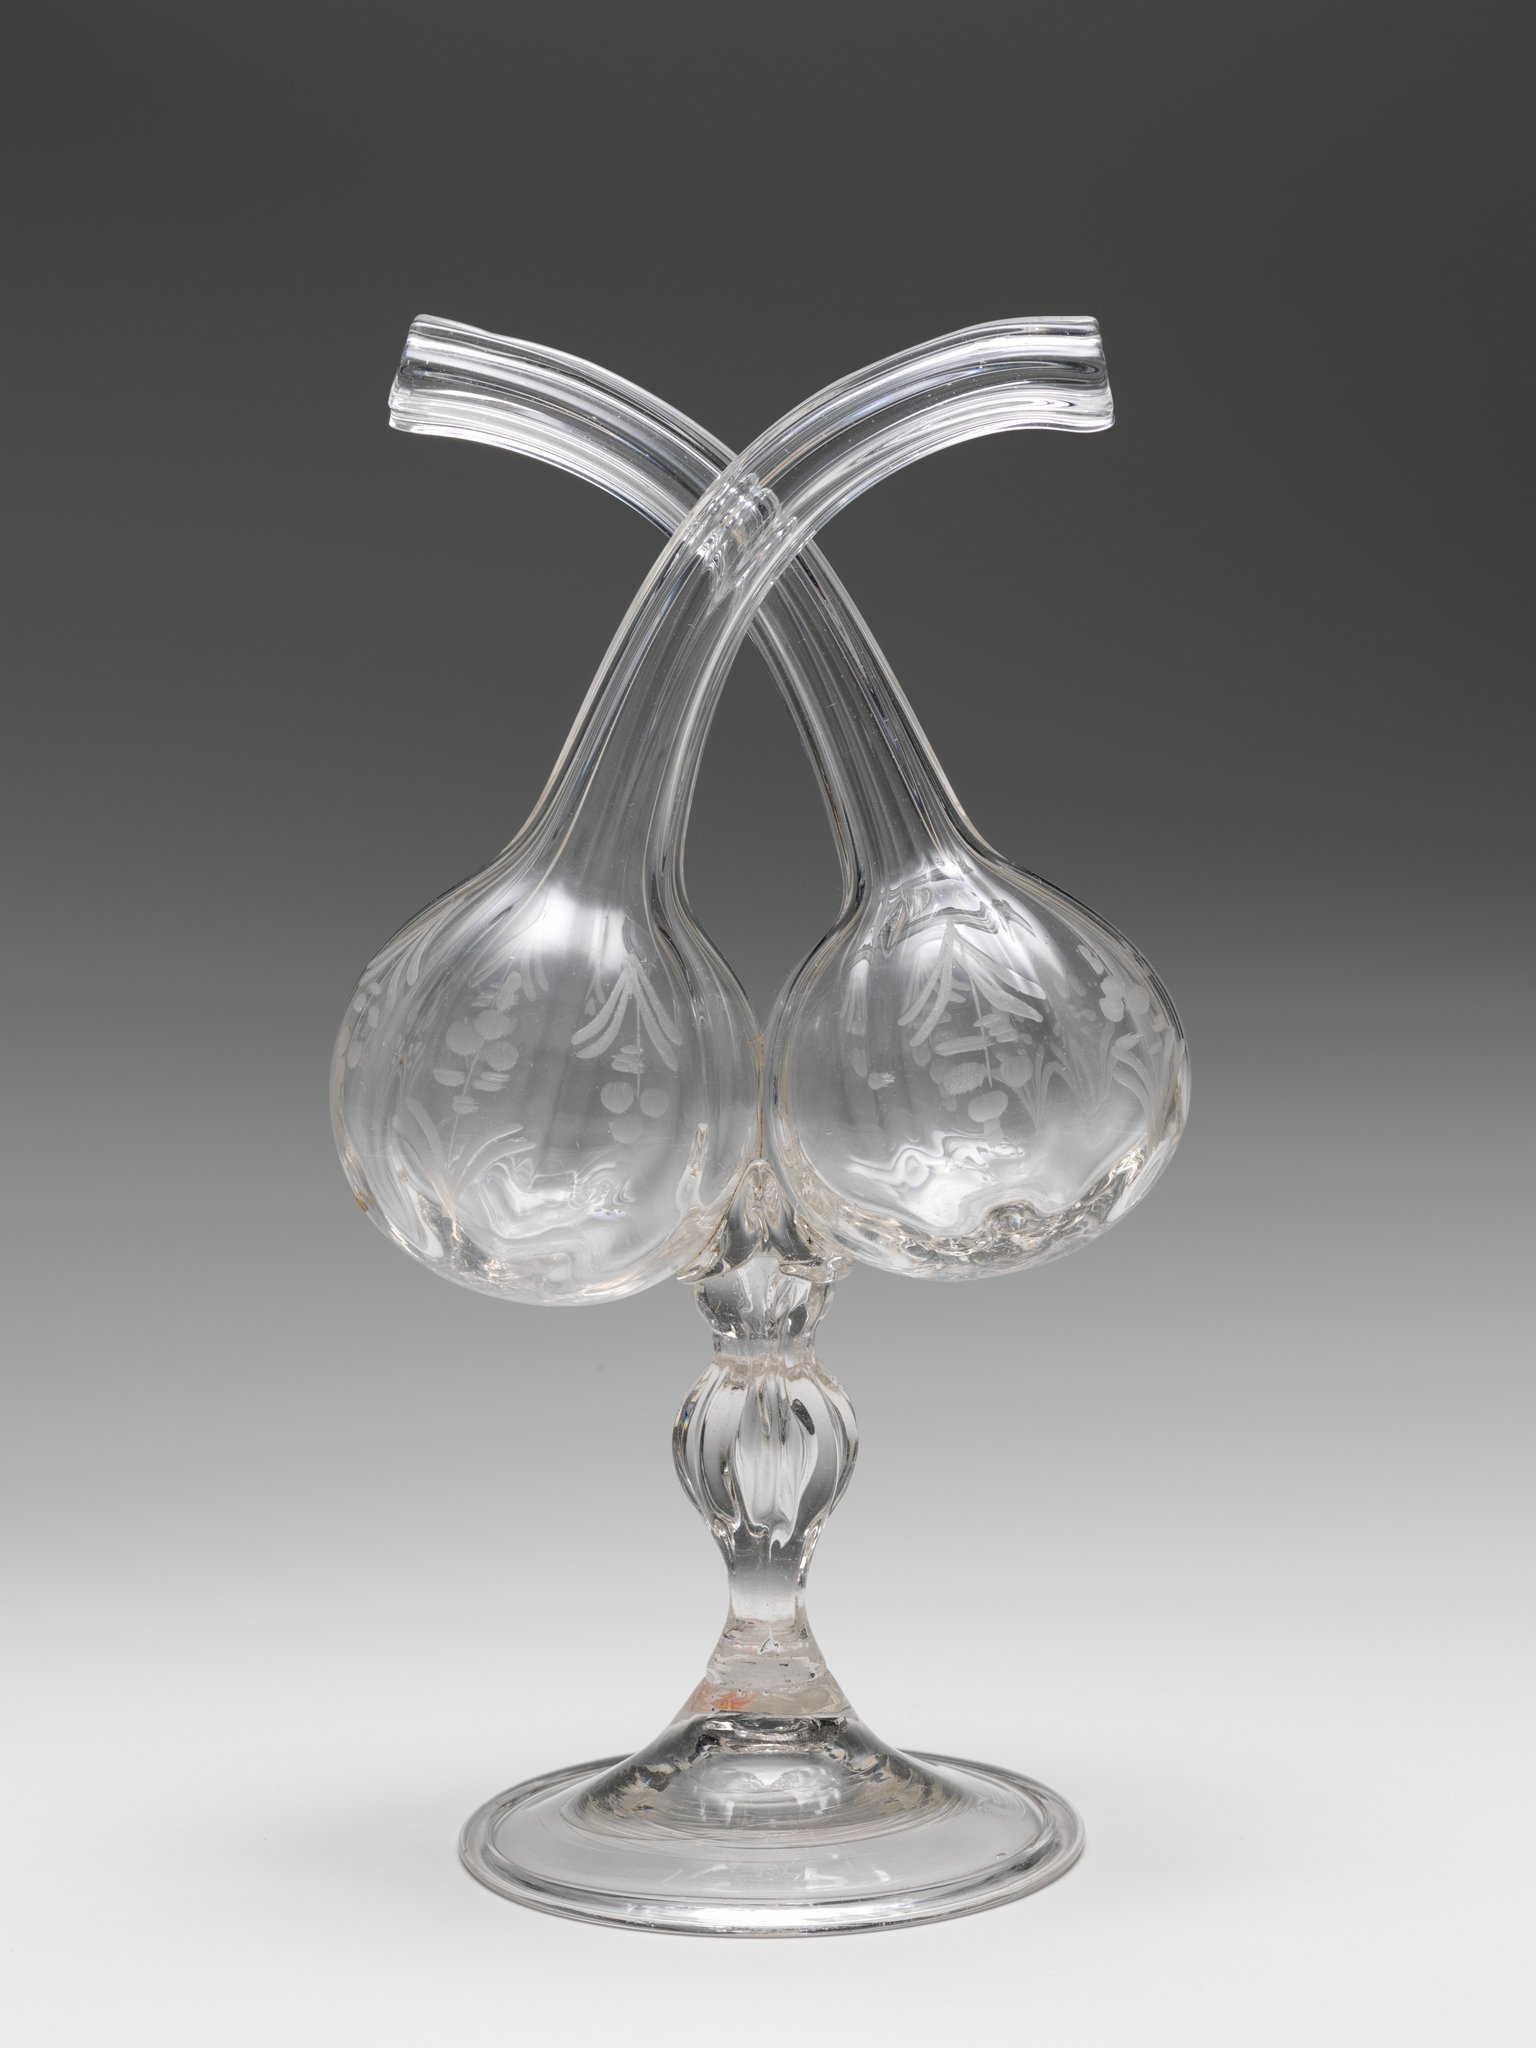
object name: double flask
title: Double flasks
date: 1701-1800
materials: glass